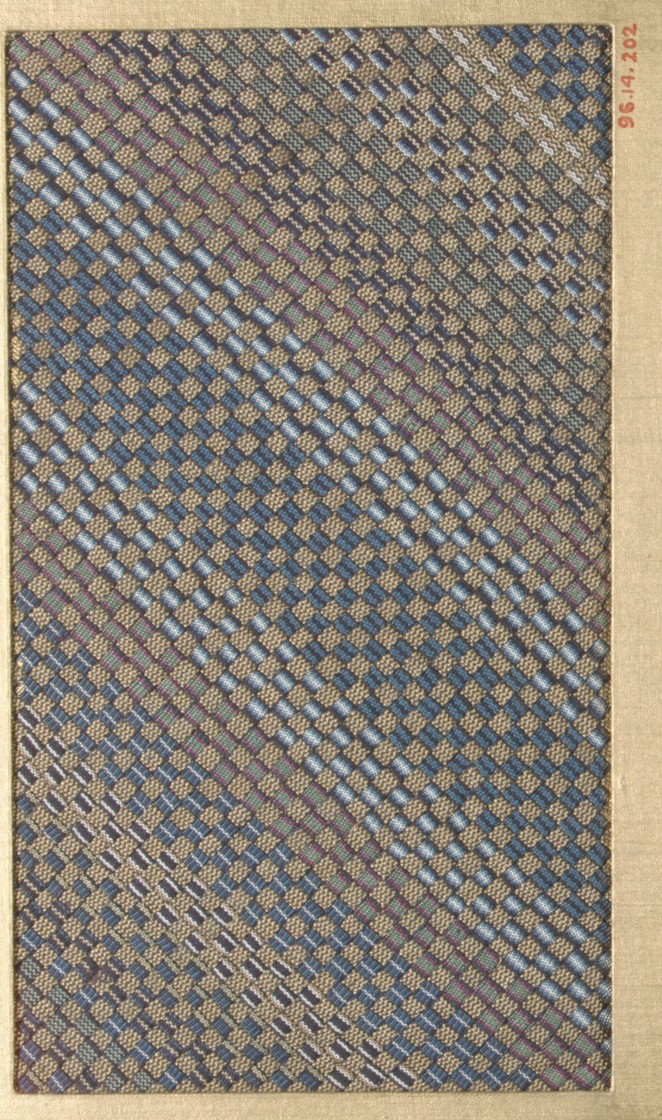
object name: piece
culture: japanese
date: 1701-1900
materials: silk